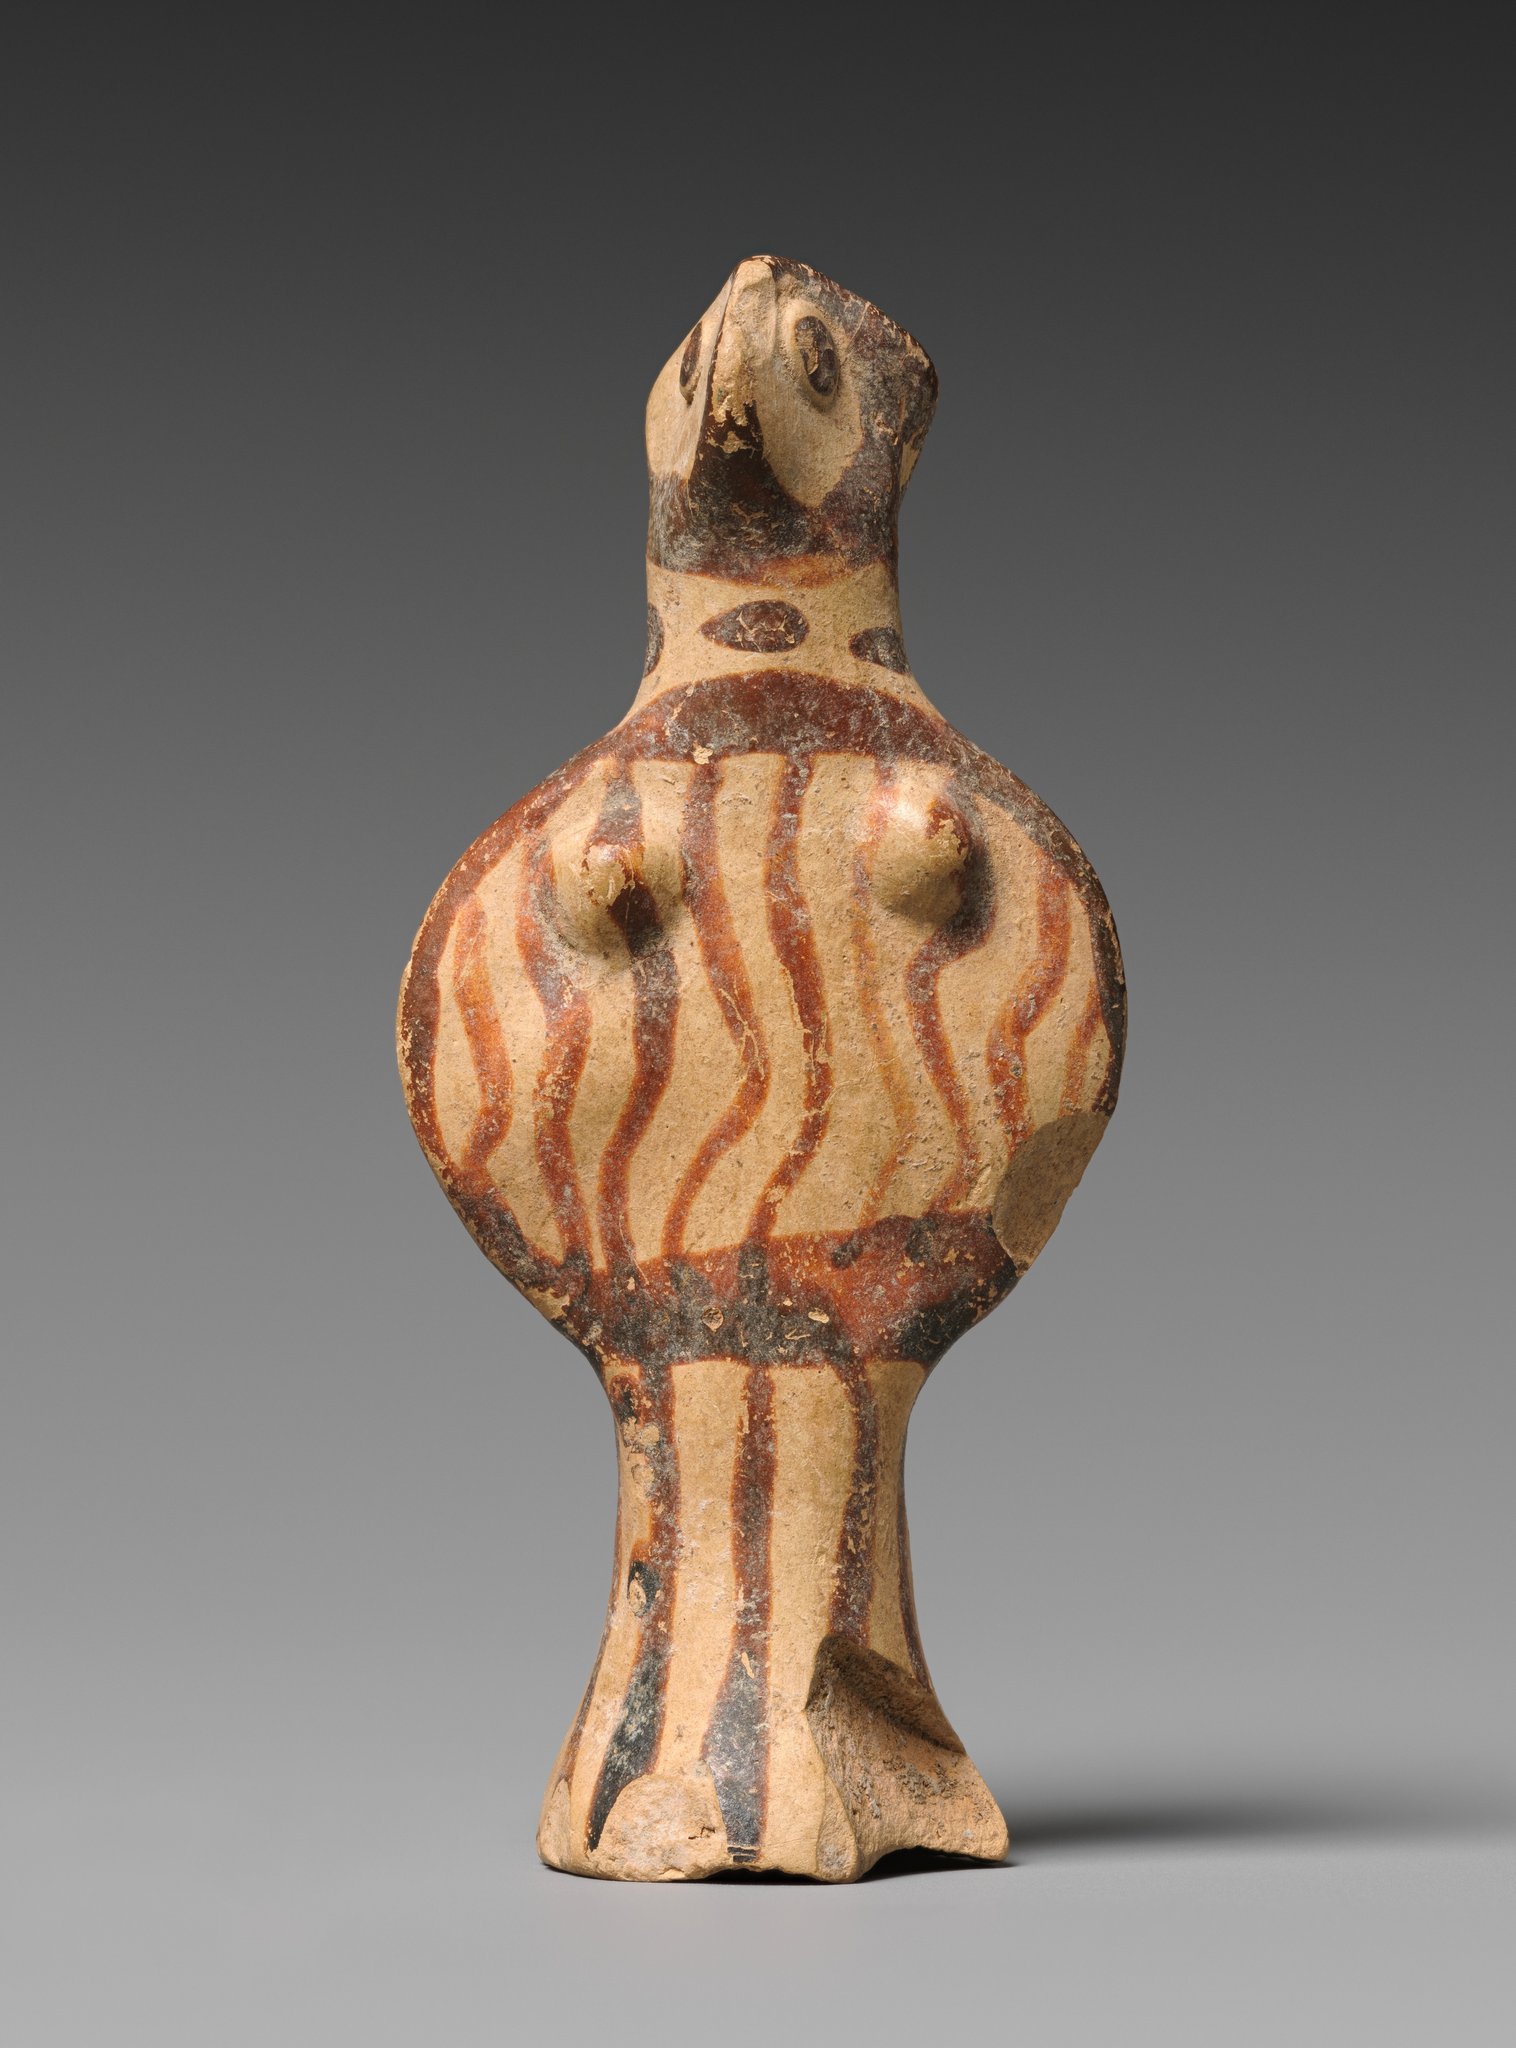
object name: statuette of a woman phi type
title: Terracotta female figure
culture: aegean, helladic or mycenaean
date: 1400-1300 BCE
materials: terracotta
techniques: painting